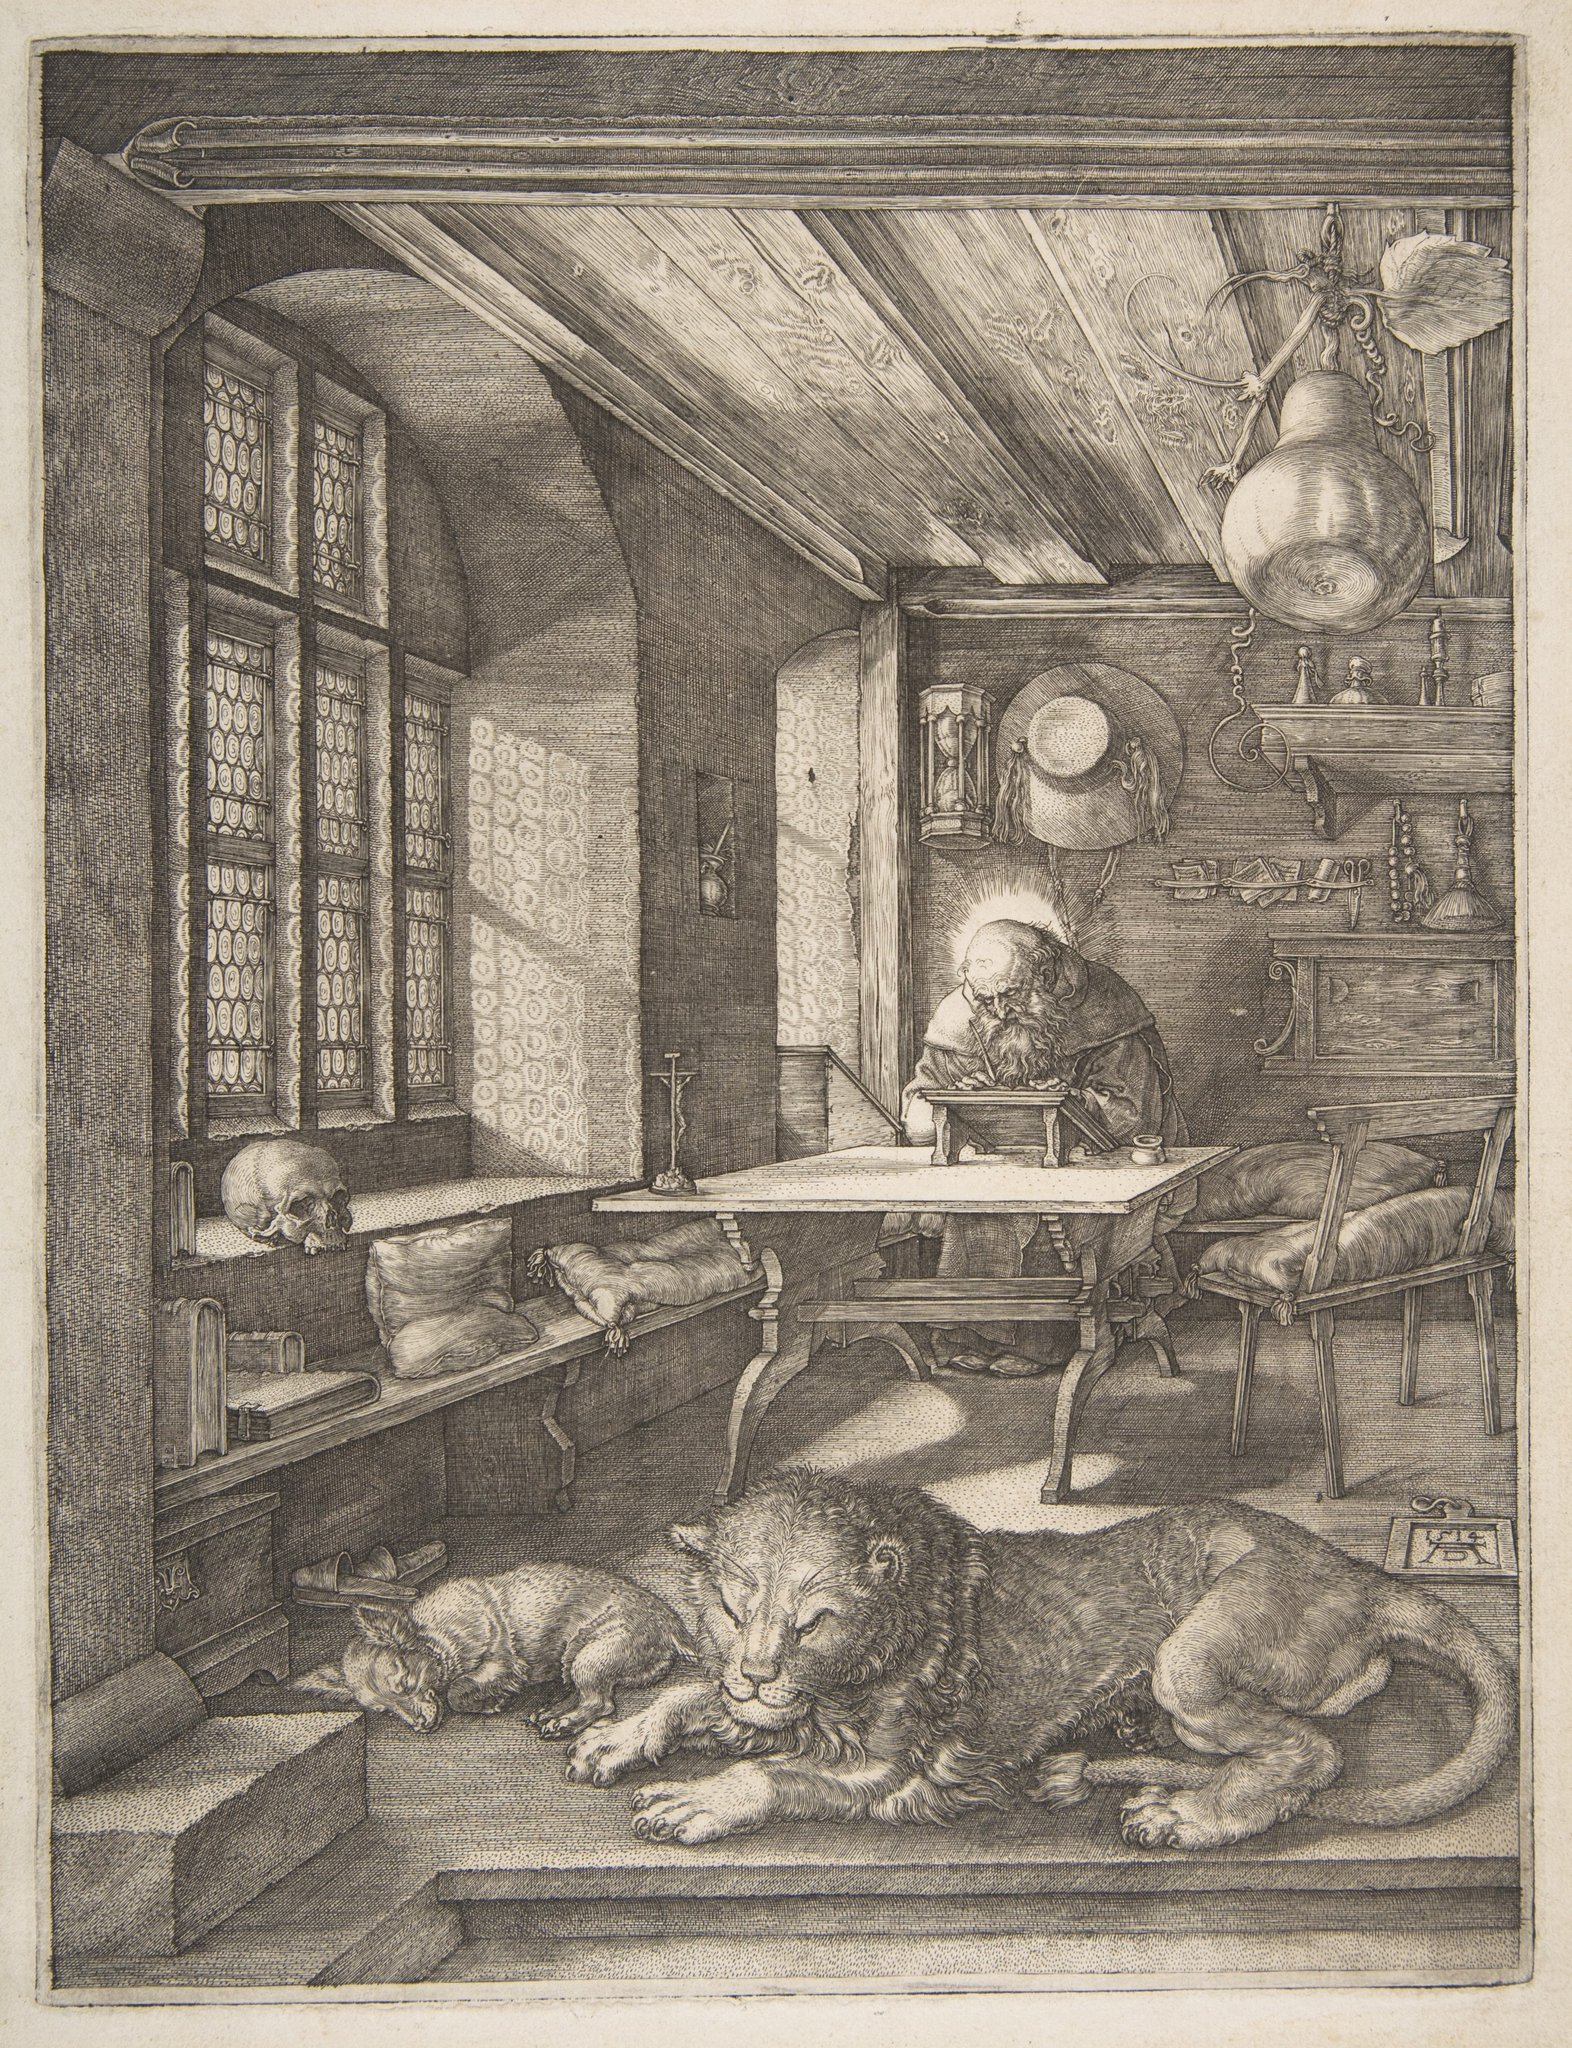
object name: print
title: Saint Jerome in His Study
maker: albrecht dürer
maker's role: artist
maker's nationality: german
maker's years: 1471-1528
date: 1514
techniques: engraving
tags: interiors,dogs,lions,saint jerome,writing